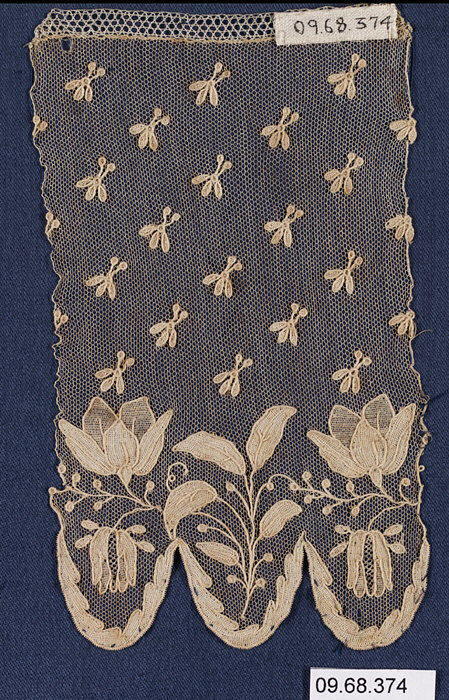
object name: fragment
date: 1801-1900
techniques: lace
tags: flowers,leaves